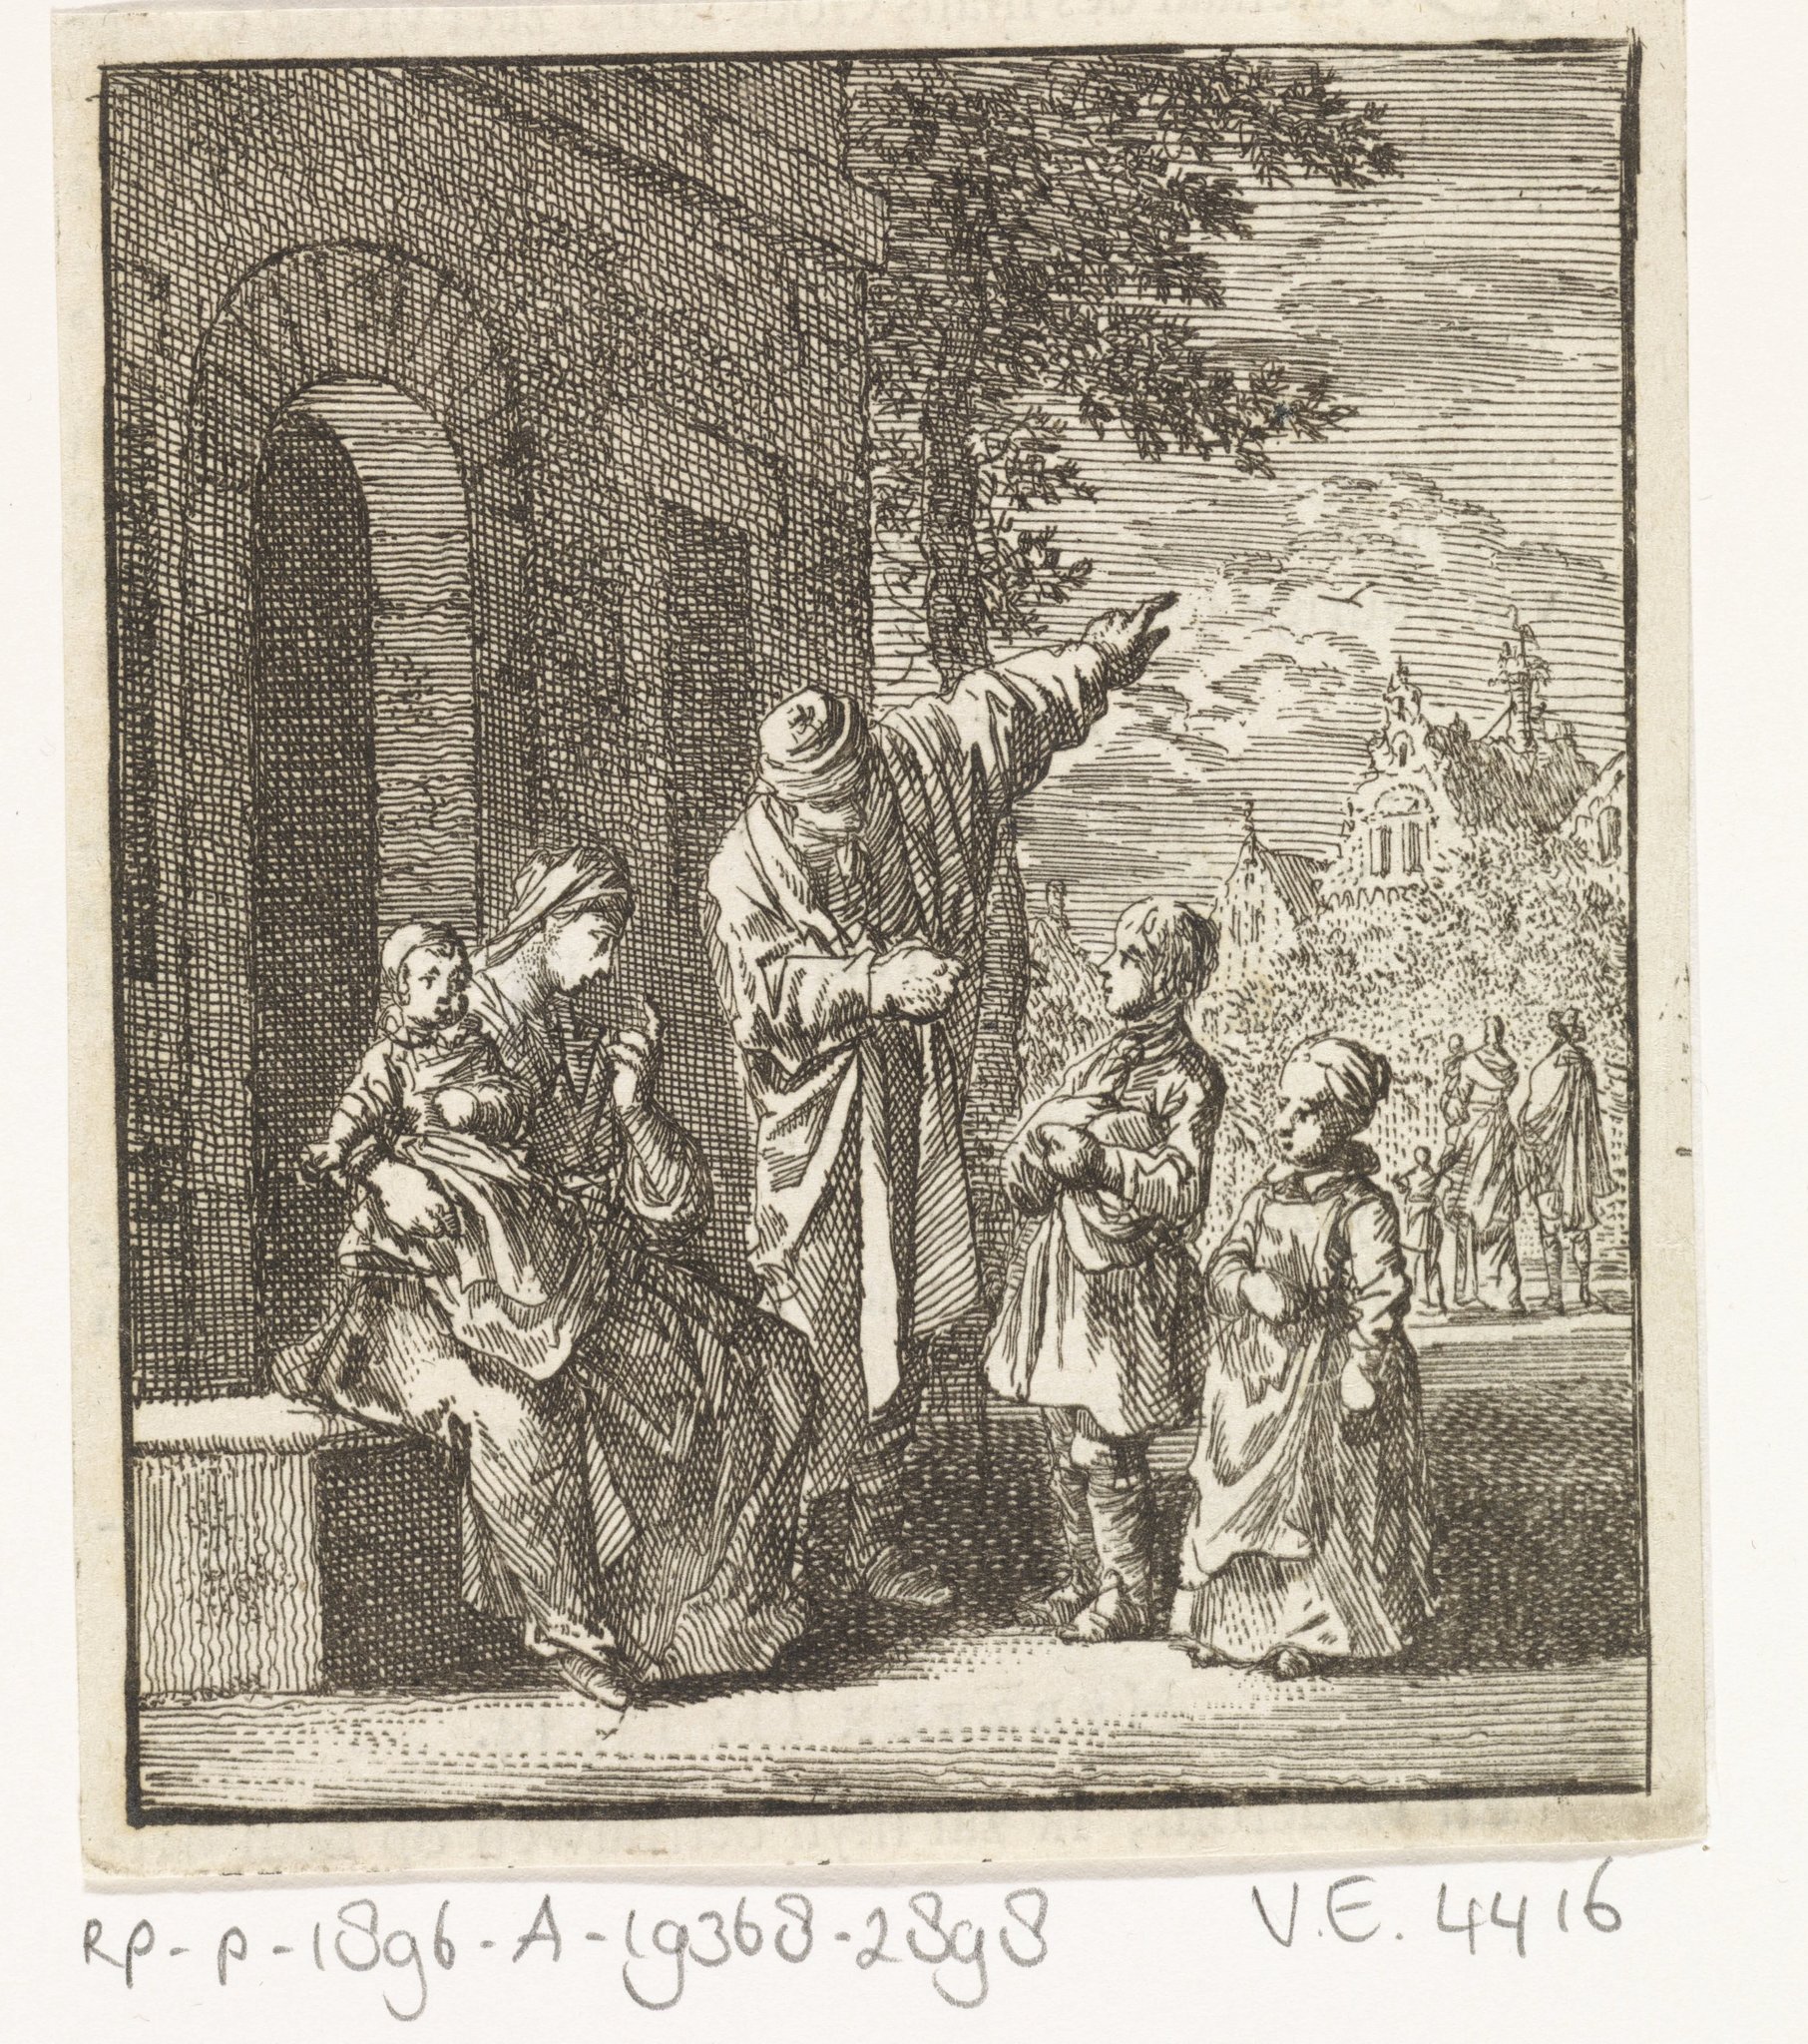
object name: print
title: Vader waarschuwt twee kinderen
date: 1712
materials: paper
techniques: etching, letterpress printing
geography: amsterdam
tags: children's games and plays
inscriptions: collector's mark: Lugt 2228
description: Illustratie uit: Luyken, Jan. Des menschen begin, midden en einde. Amsterdam: Wed. Pieter Arentsz II en Cornelis van der Sys, 1712, p. 59.